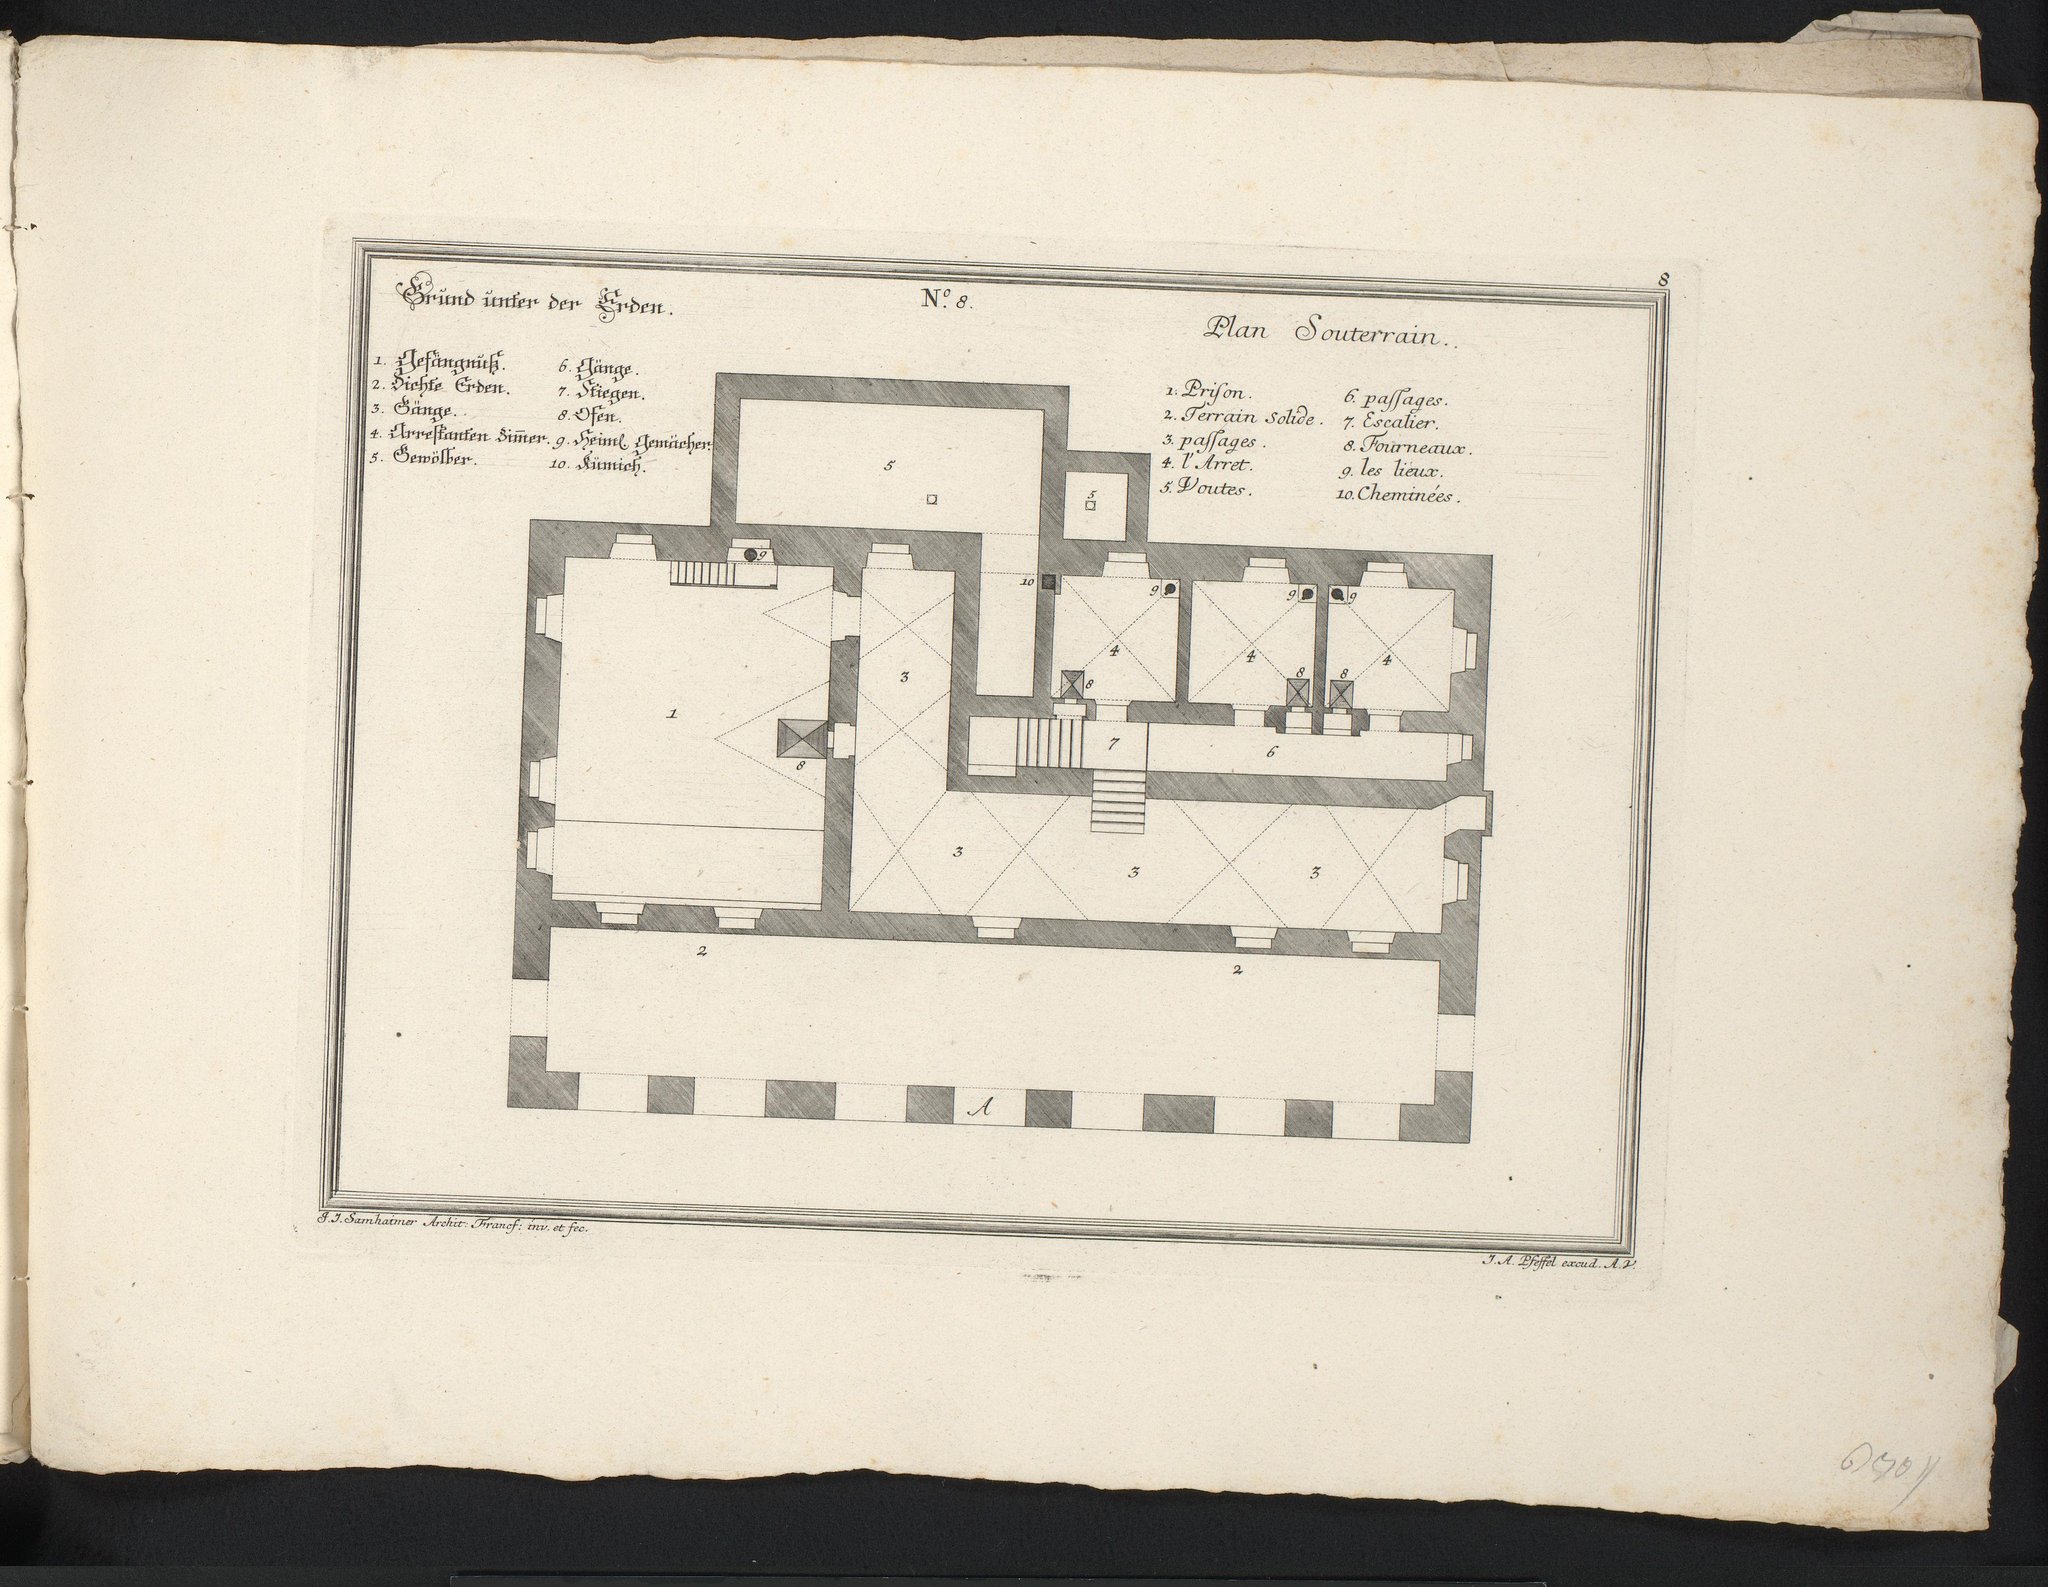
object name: print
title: Gündriss unter der Erden / Plan souterrain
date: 1729-1730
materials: paper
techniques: engraving, etching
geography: augsburg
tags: prison, jail, barracks, plan ~ architecture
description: Boven, in het midden, en rechtsboven genummerd: 8.